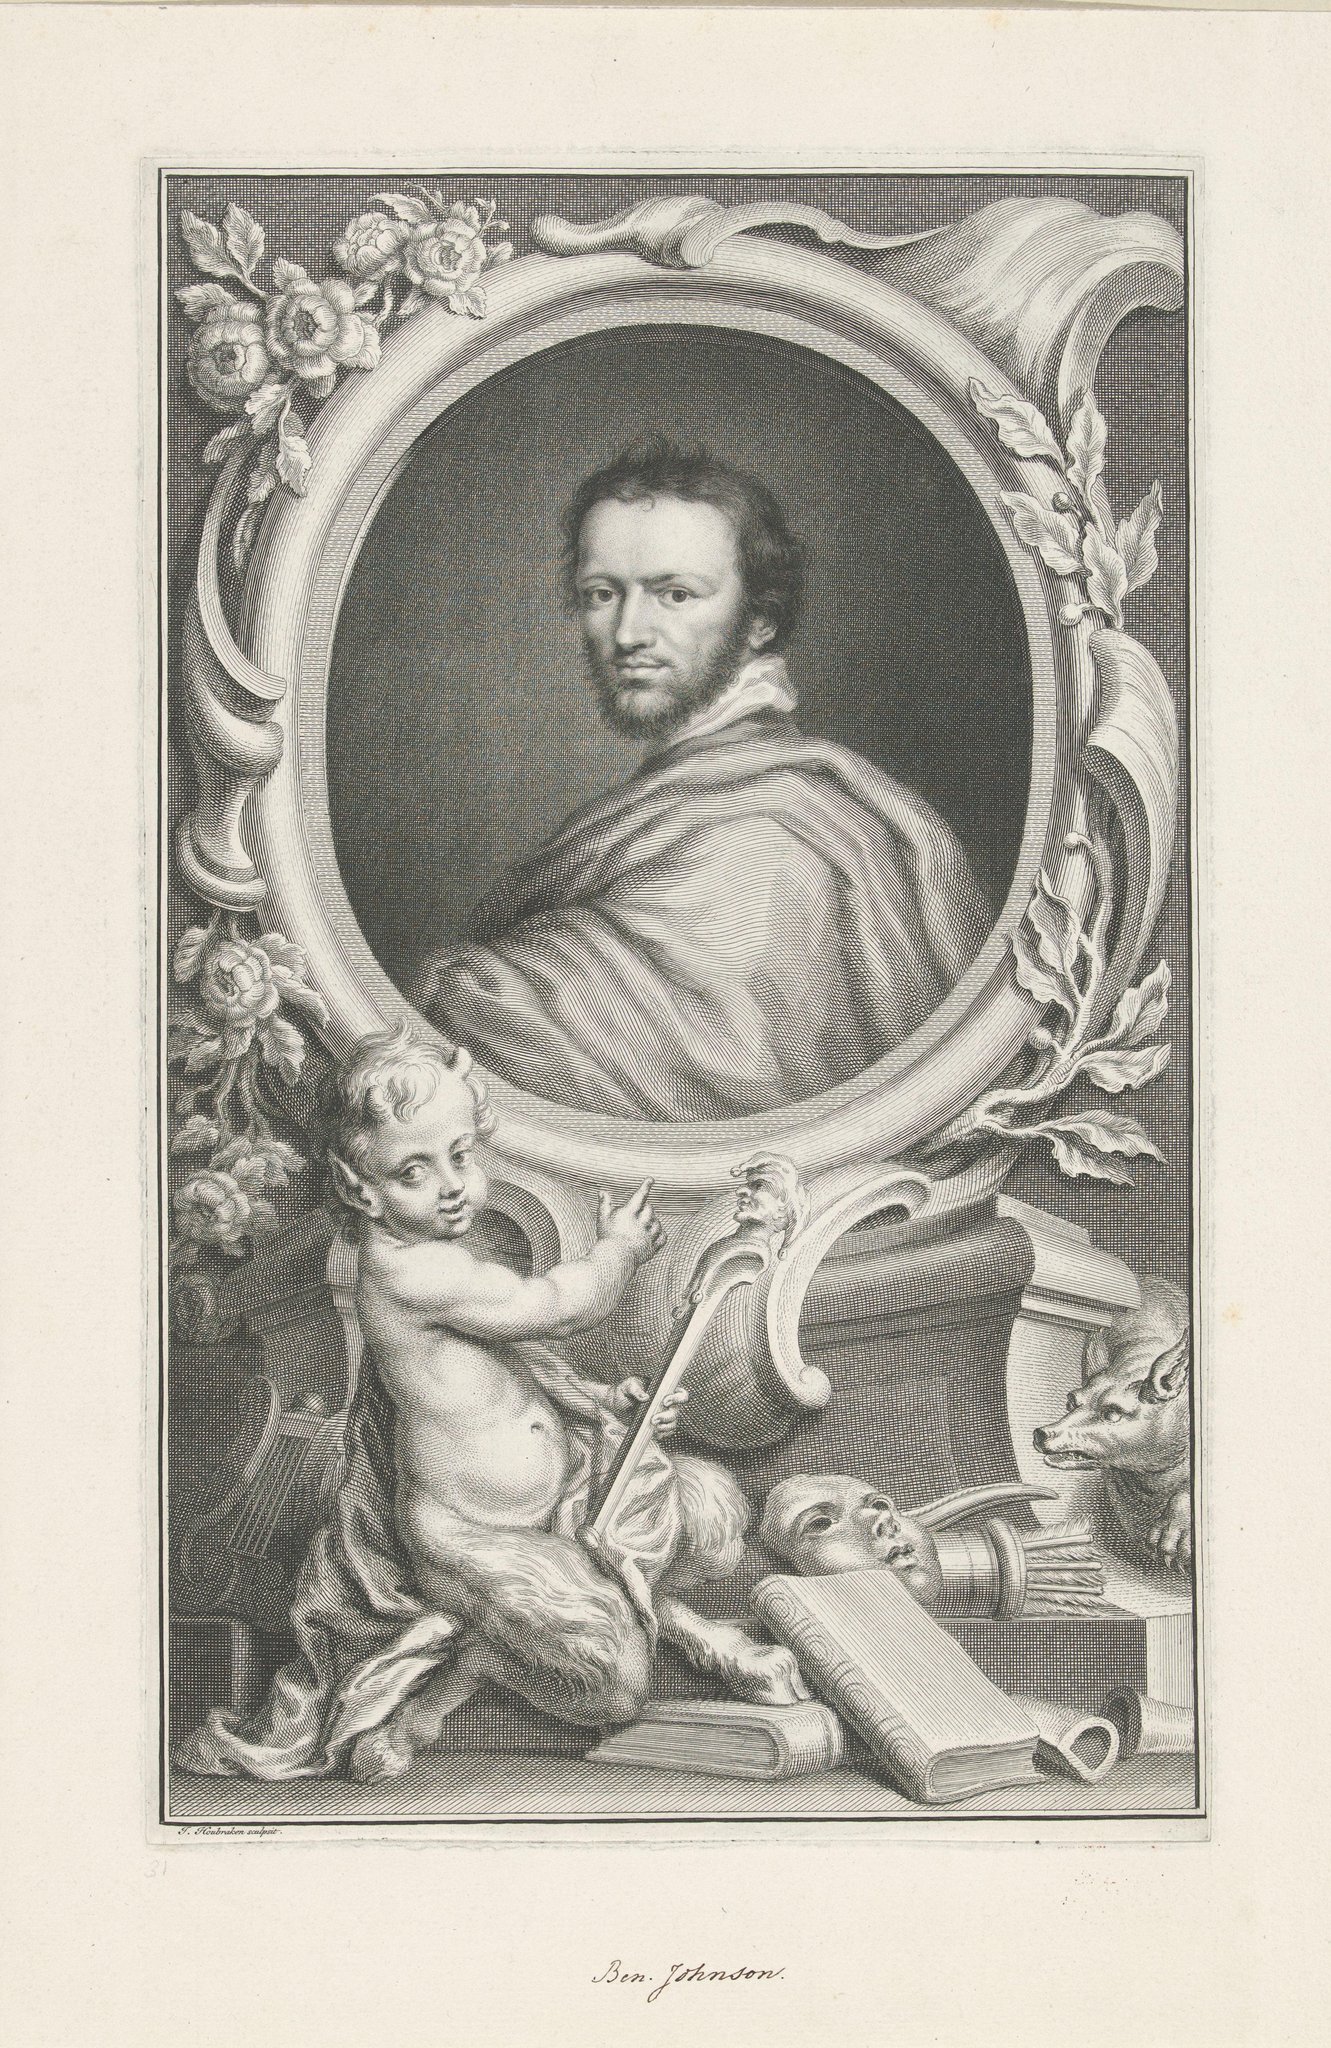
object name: print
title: Portret van Benjamin Jonson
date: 1736-1738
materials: paper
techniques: engraving, etching, pen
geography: amsterdam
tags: acteur, toneelschrijver, benjamin jonson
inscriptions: name: ‘Ben. Johnson’, collector's mark: Lugt 240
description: Portret van de toneelschrijver, acteur en dichter Benjamin Jonson, met onder het portret een jonge sater met een narrenkop op een stok, omringd door attributen van Apollo als beschermgod van de poëzie en de kunsten; lier, masker, wolf en pijlenkoker.